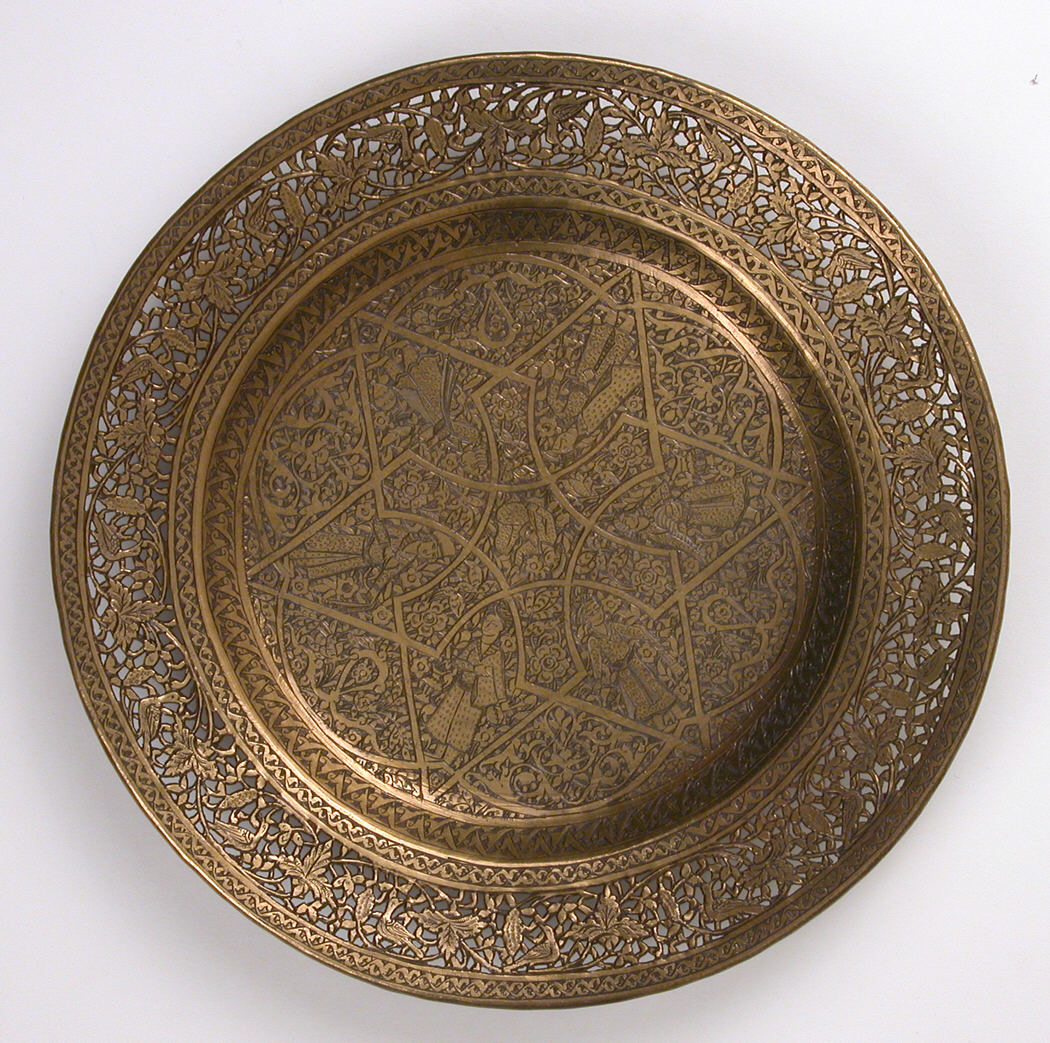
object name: plate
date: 1701-1800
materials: brass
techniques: engraving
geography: iran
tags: men